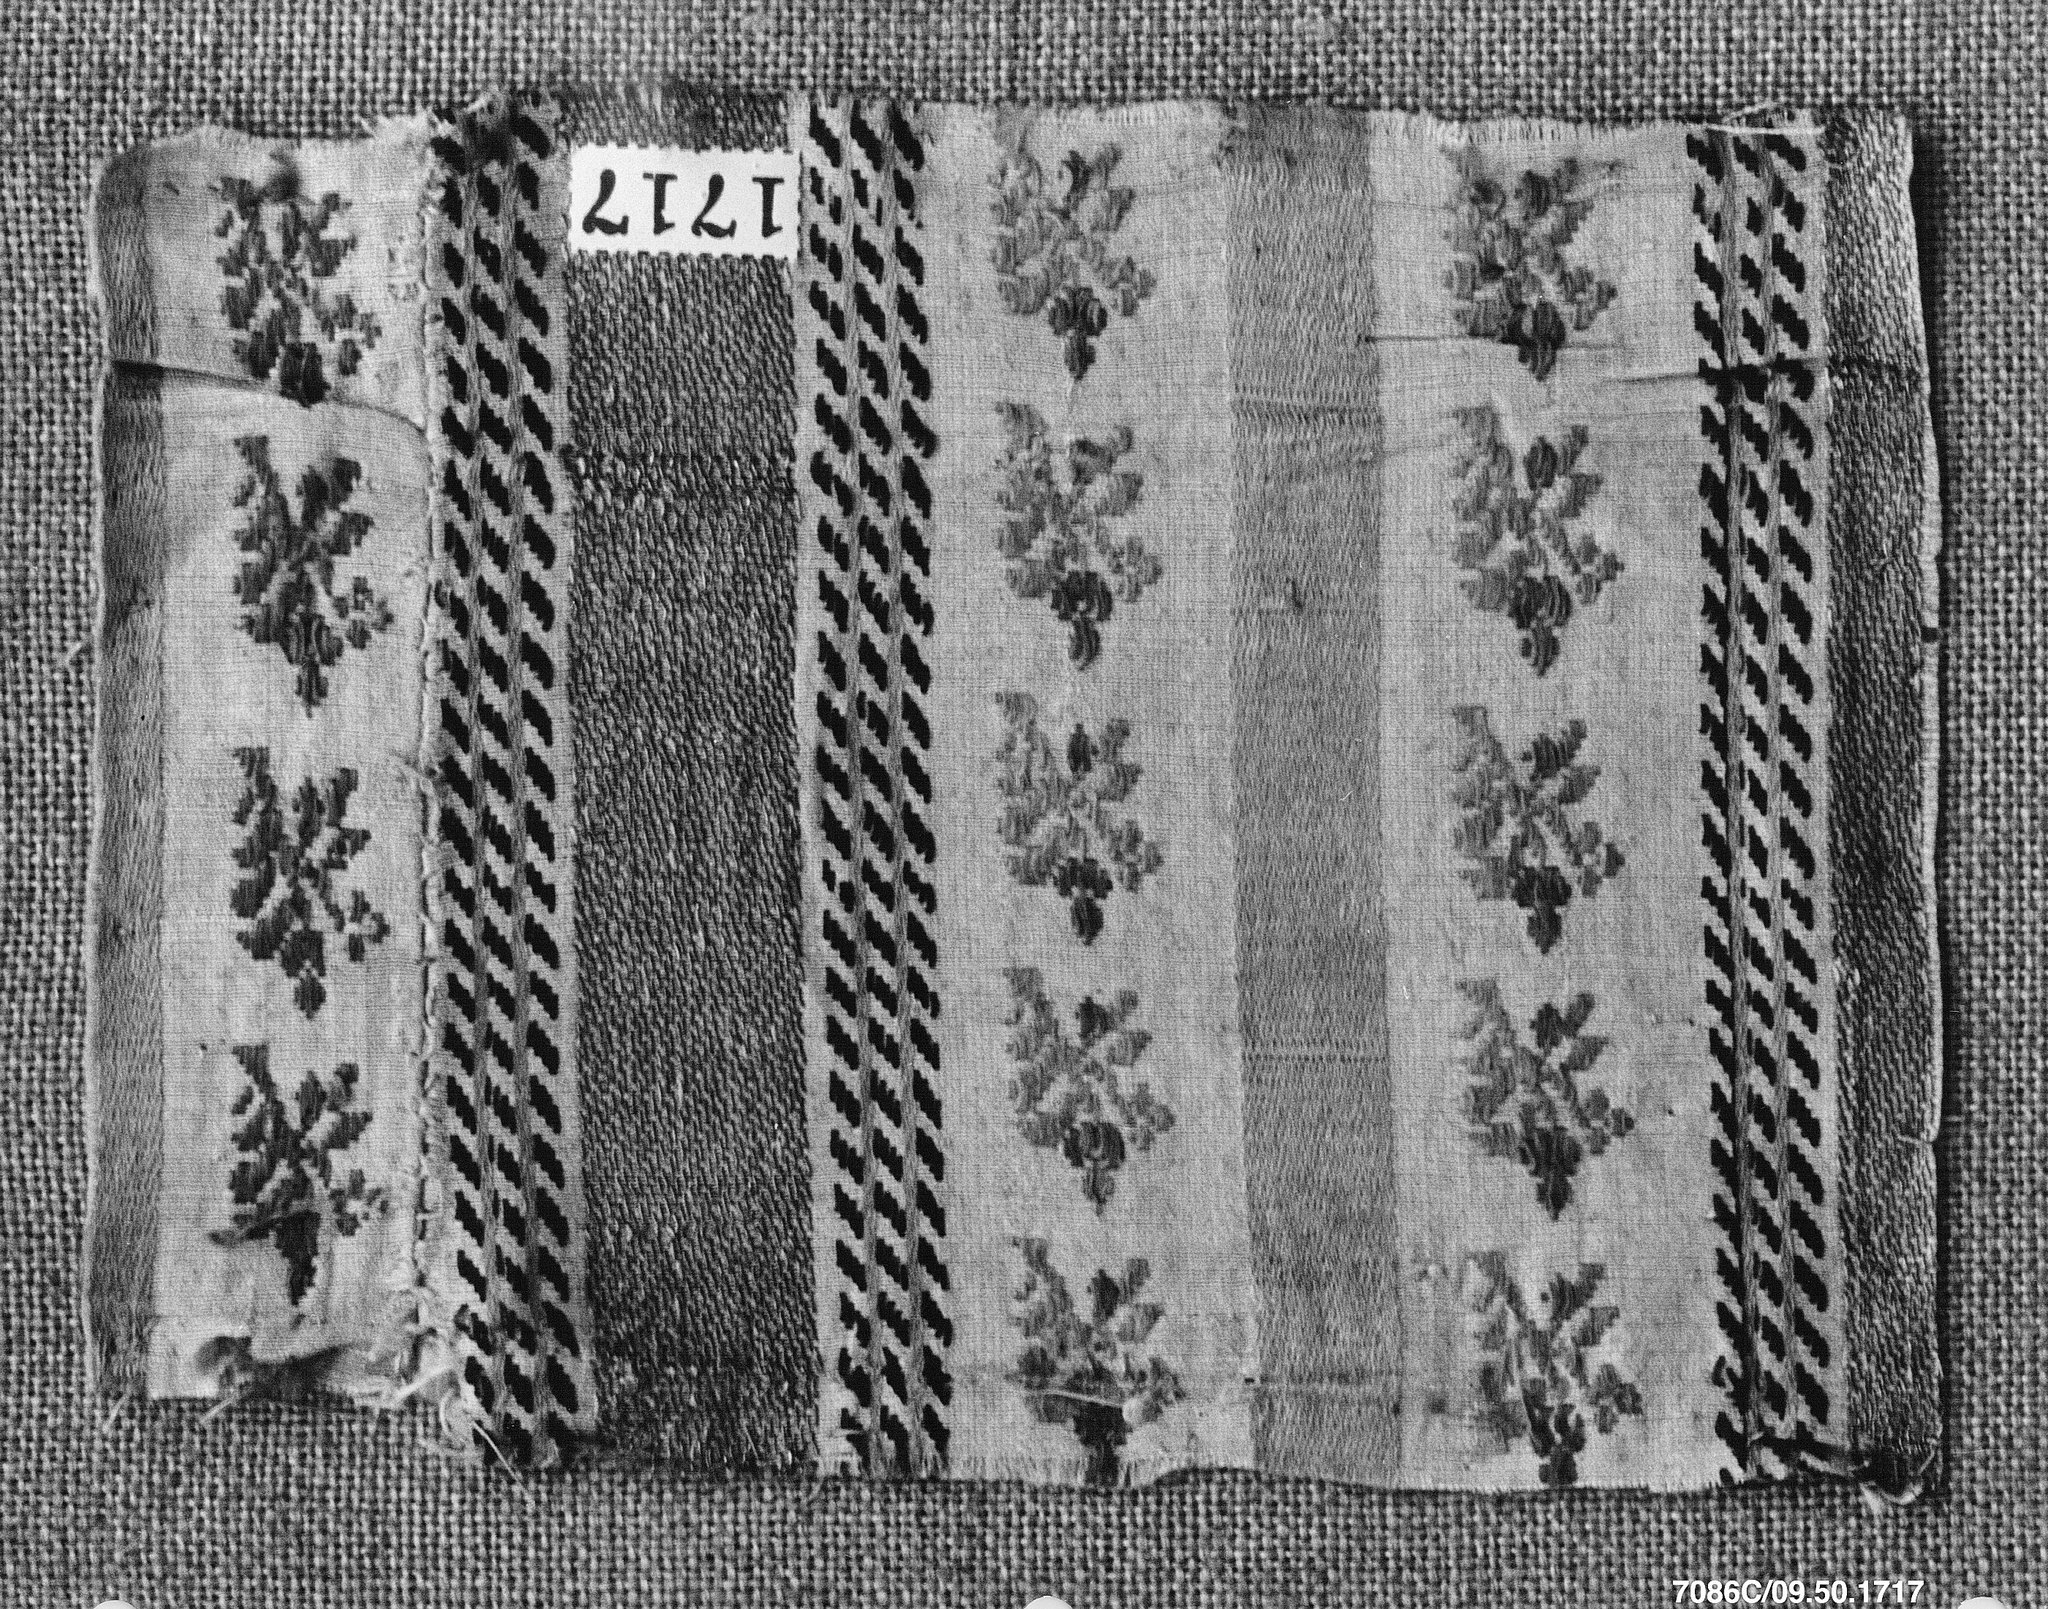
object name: piece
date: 1701-1800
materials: cotton, metal thread, silk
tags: leaves